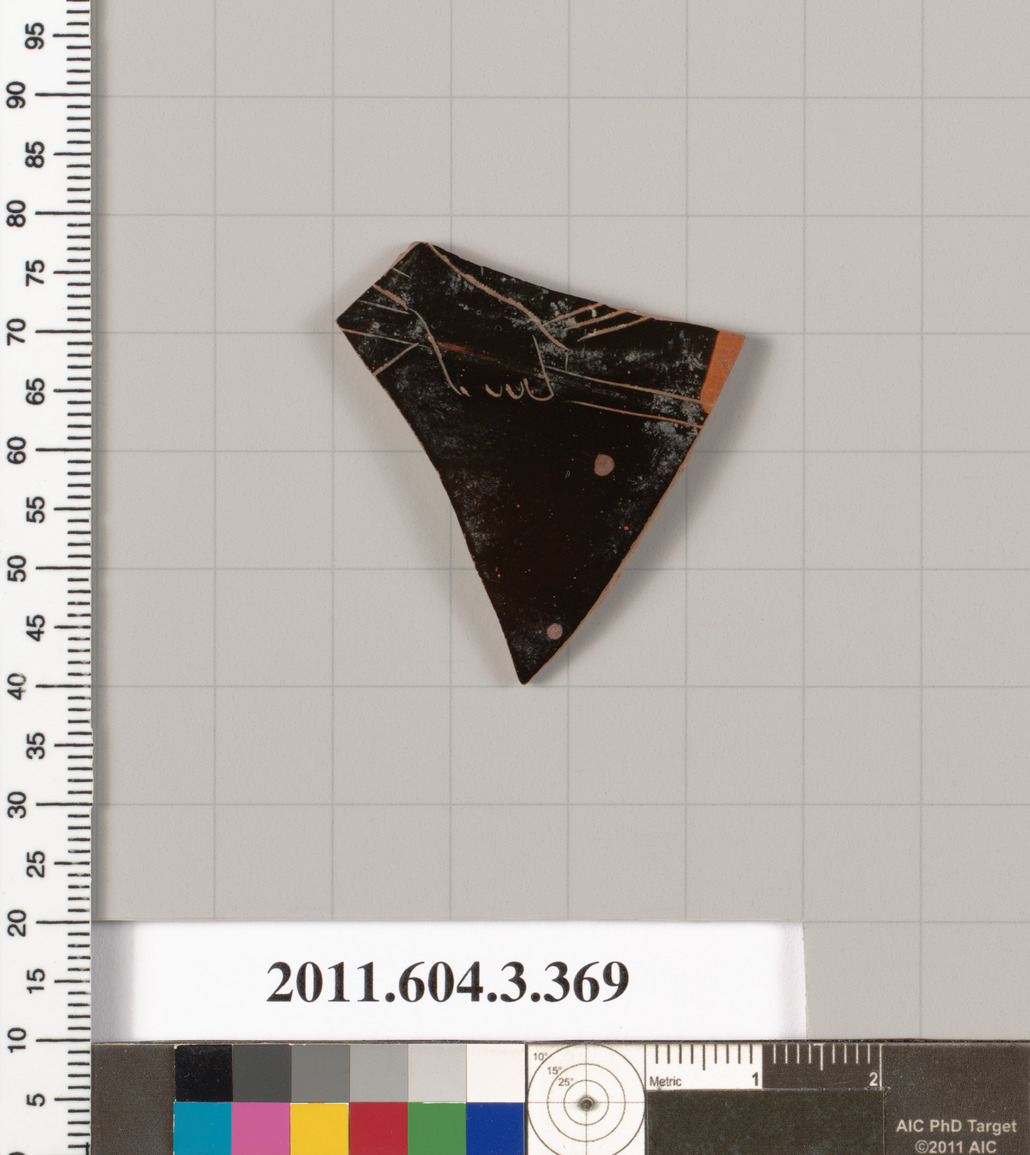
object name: neck amphora fragment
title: Terracotta fragment of a neck-amphora (jar)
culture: greek, attic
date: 550-526 BCE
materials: terracotta